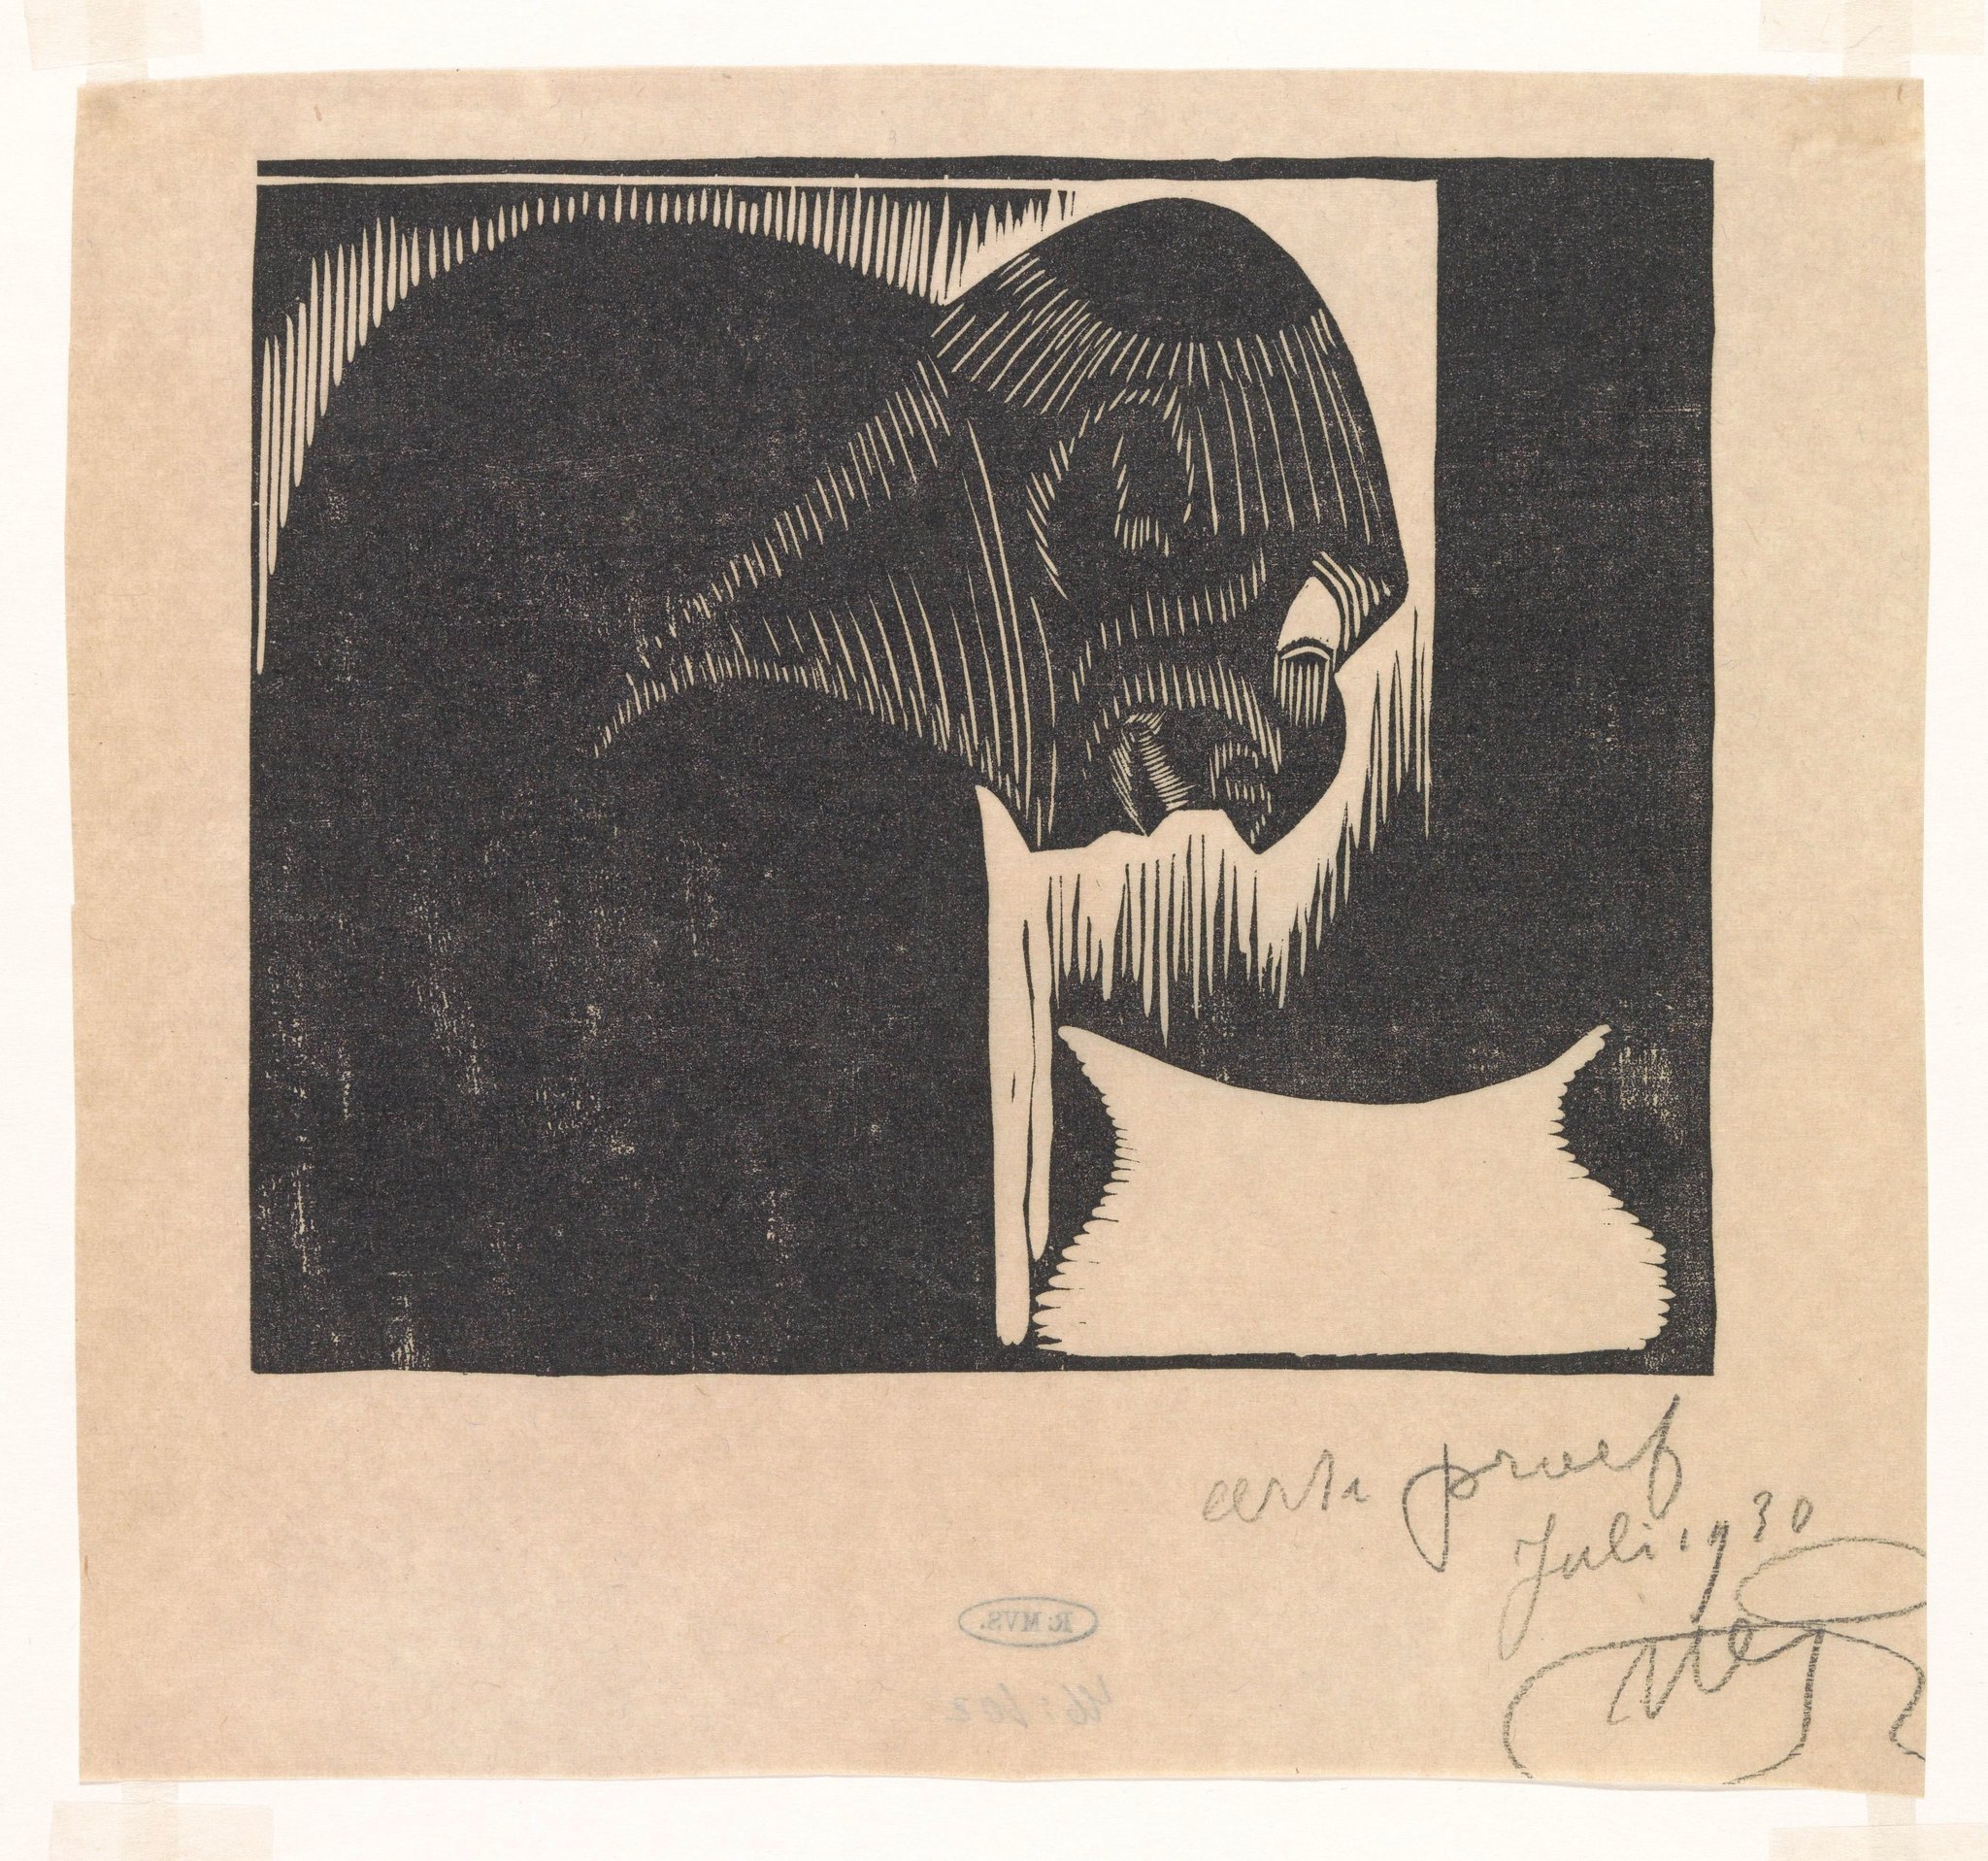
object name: print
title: Fantasie: een profiel met een haviksneus buigt zich over een witte kom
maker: samuel jessurun de mesquita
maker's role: draughtsman, print maker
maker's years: 1868-1944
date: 1907-1930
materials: paper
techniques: woodcut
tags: head bent forward; bowing, bowl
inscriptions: collector's mark: Lugt 2228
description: Een man met een haviksneus buigt zich over een witte kom.